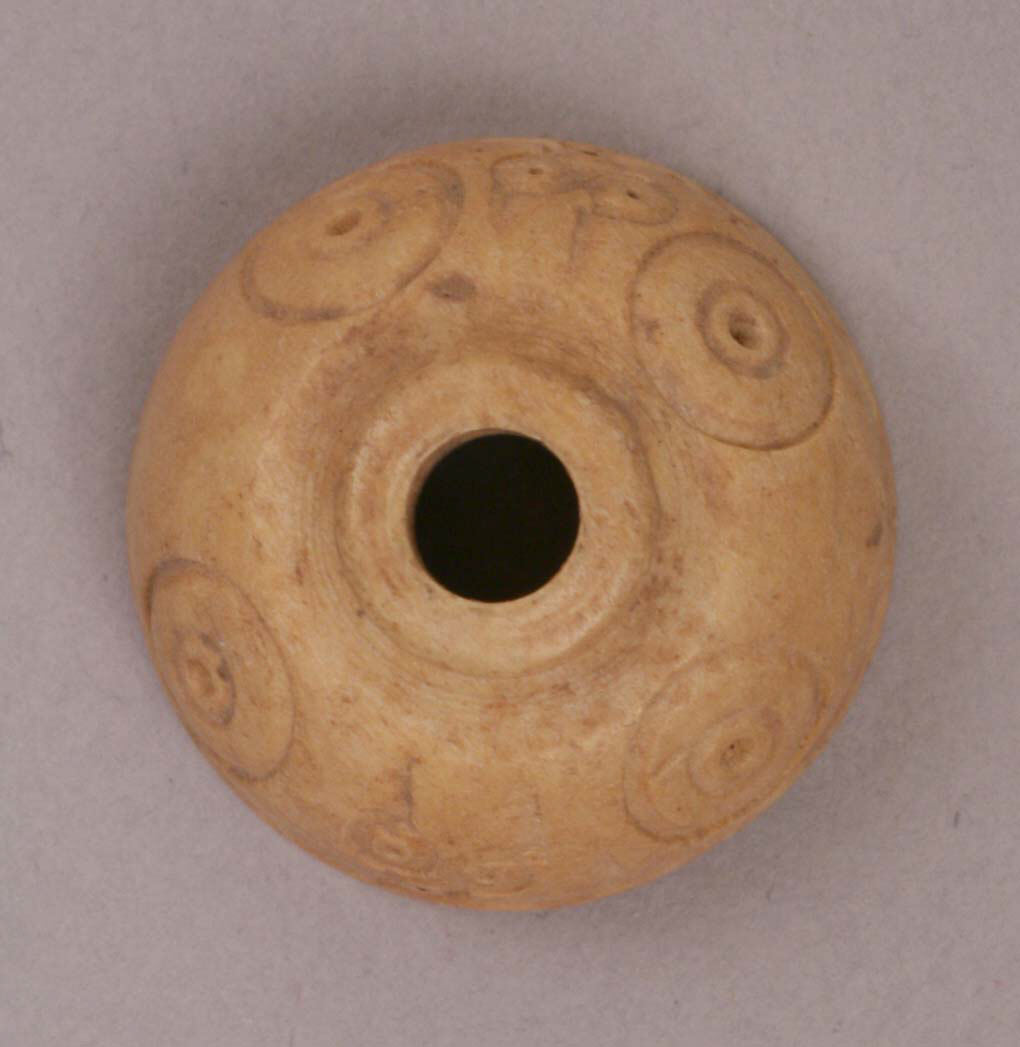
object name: button or bead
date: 801-1000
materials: bone, paint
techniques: incising, inlay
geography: iran